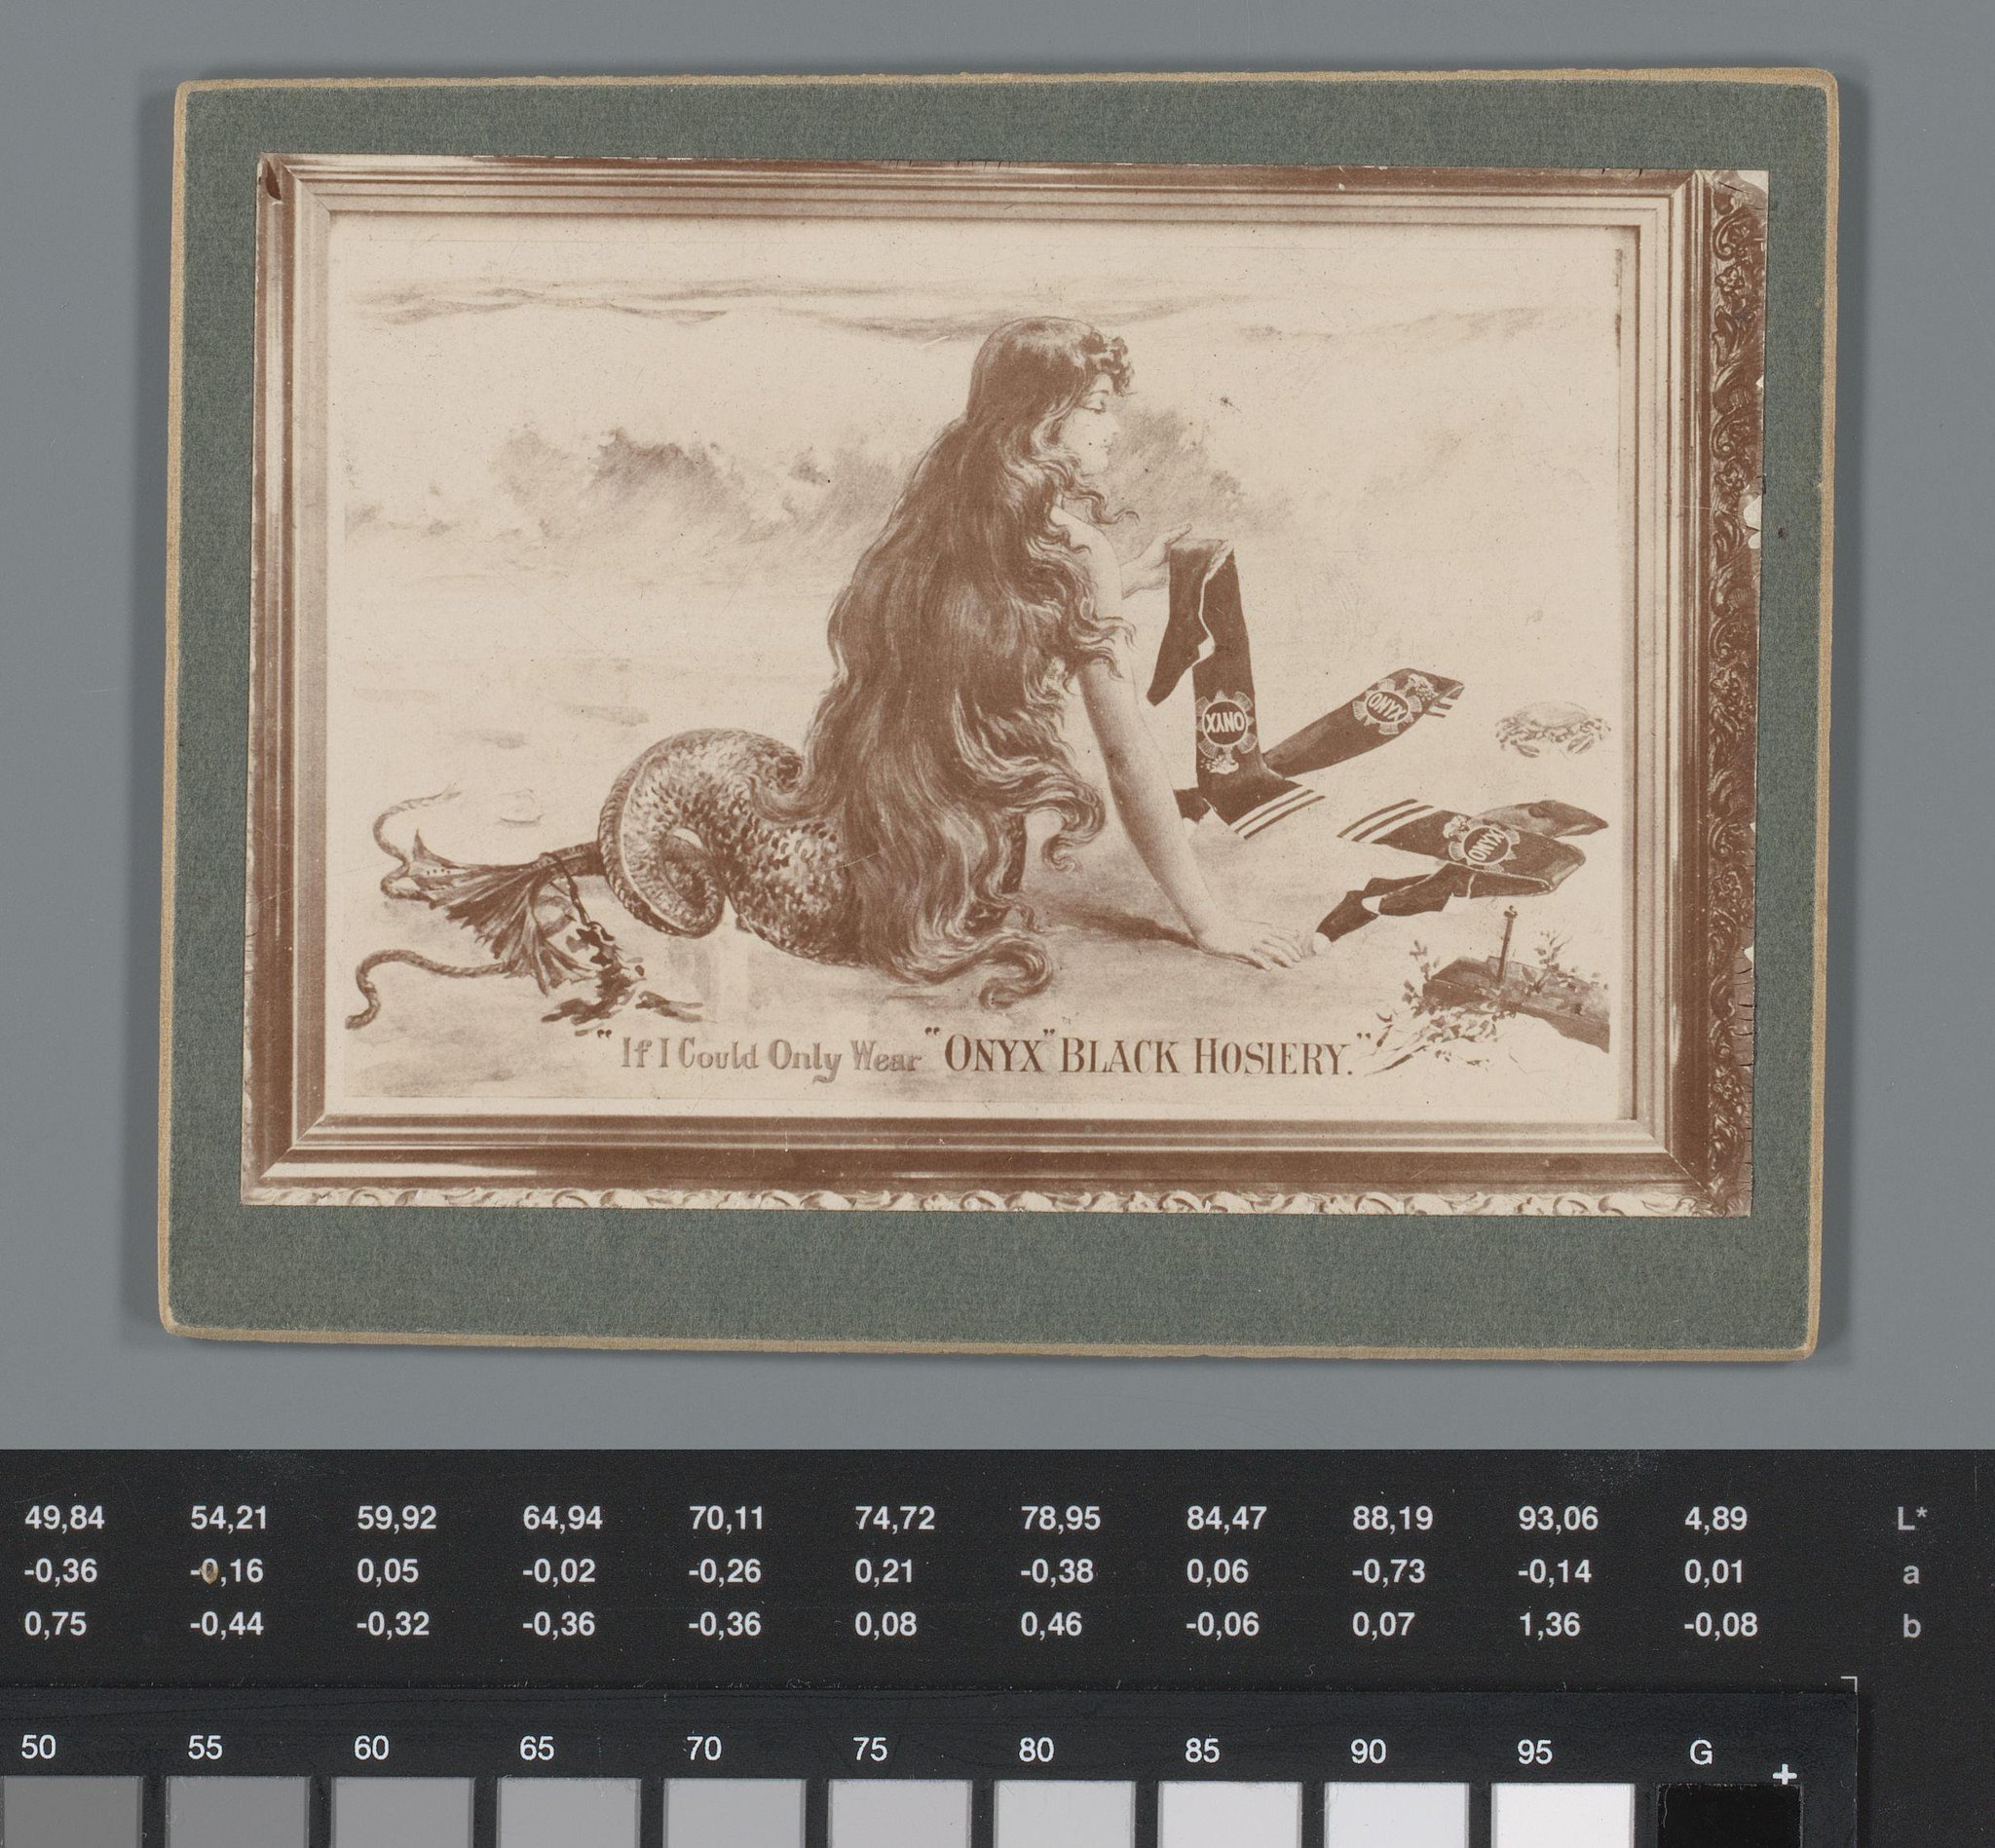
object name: reproduction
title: Reclame voor zwarte kousen van Onyx met reproductie van een prent van een zeemeermin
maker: Anonymous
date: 1850-1915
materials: cardboard, photographic support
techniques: albumen print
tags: advertising, merman - aa - mermaid, siren, stockings, socks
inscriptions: inscription: ‘If I Could Only Wear "ONYX" BLACK HOSIERY.’